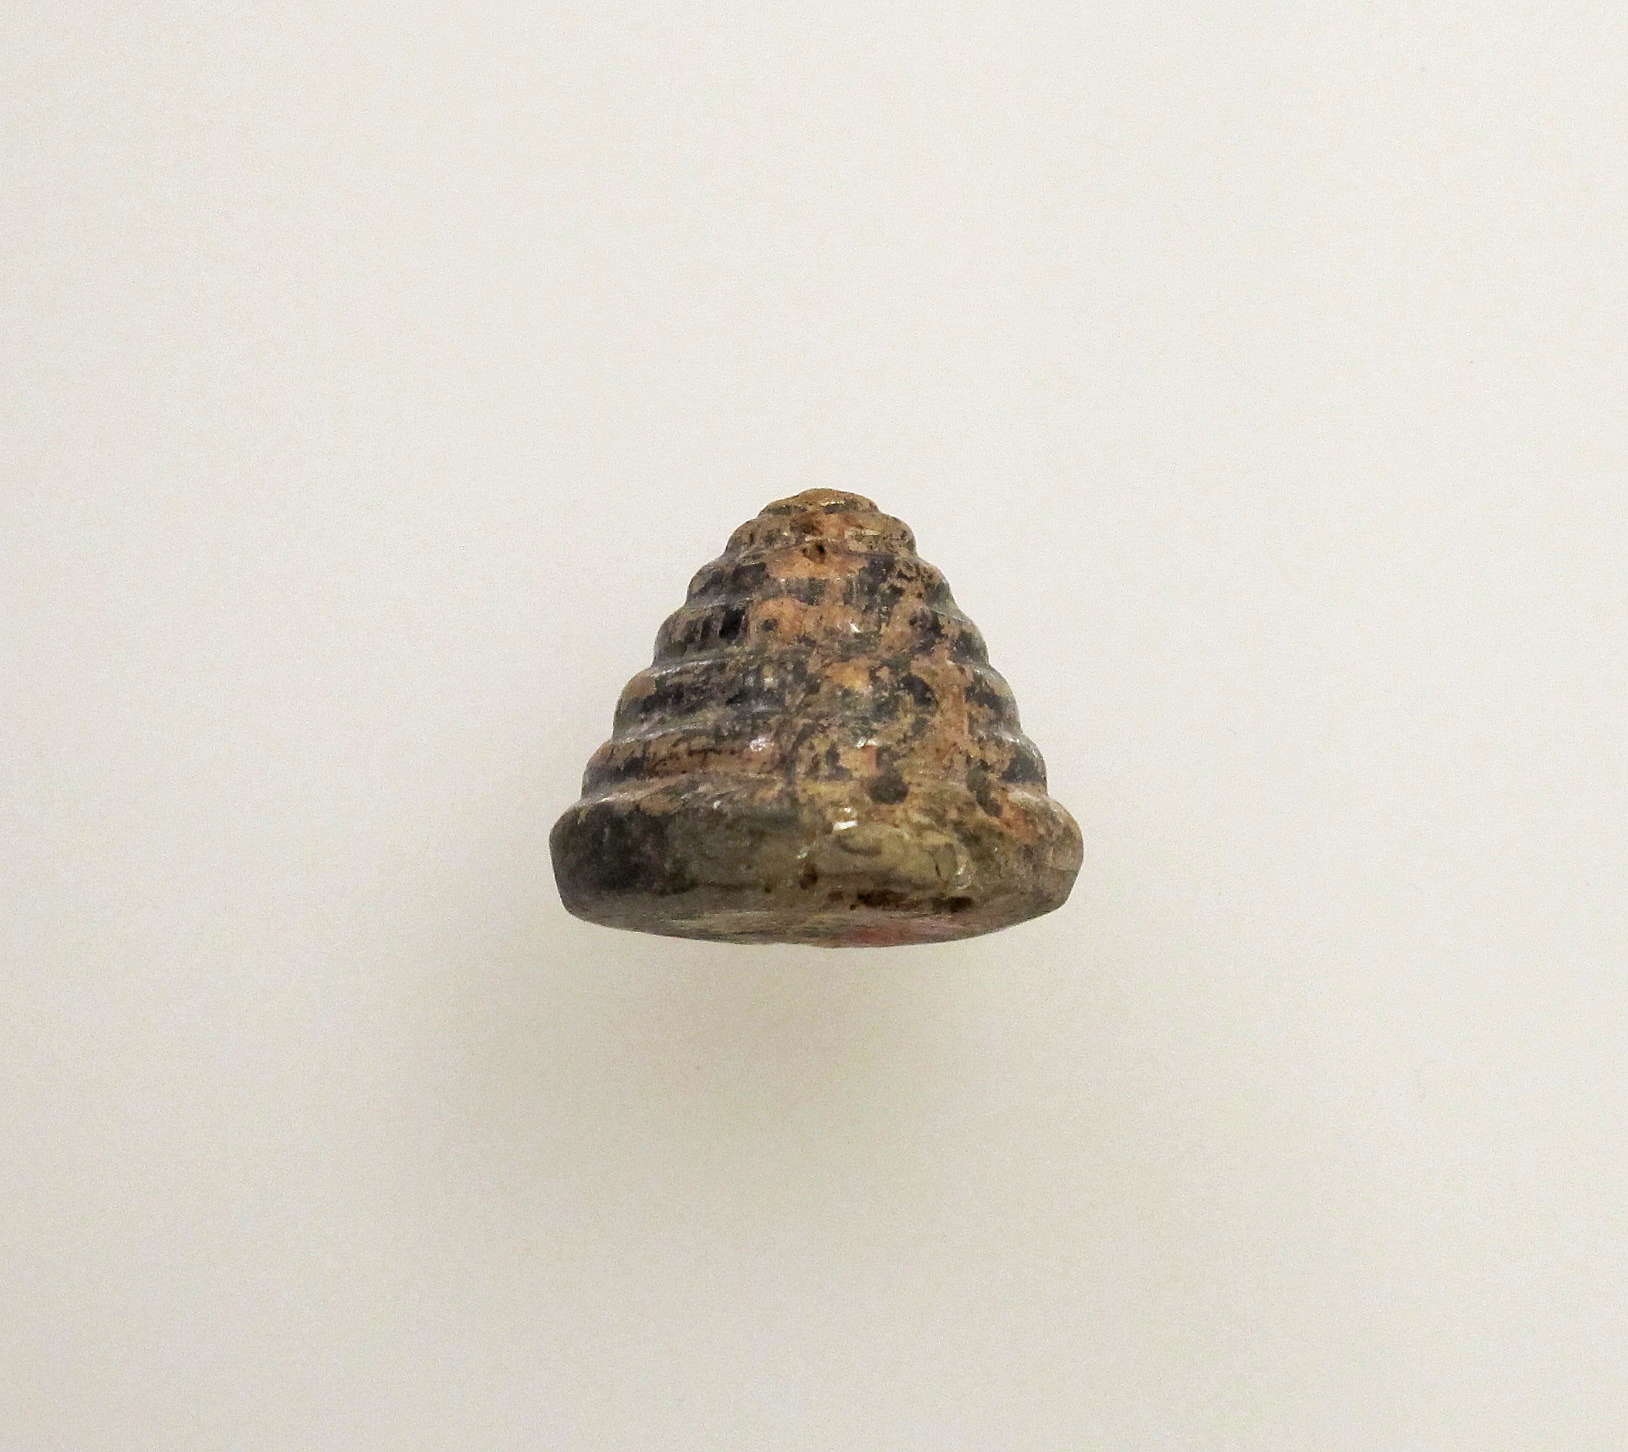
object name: spindle whorl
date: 7000 BCE-330 CE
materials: glass